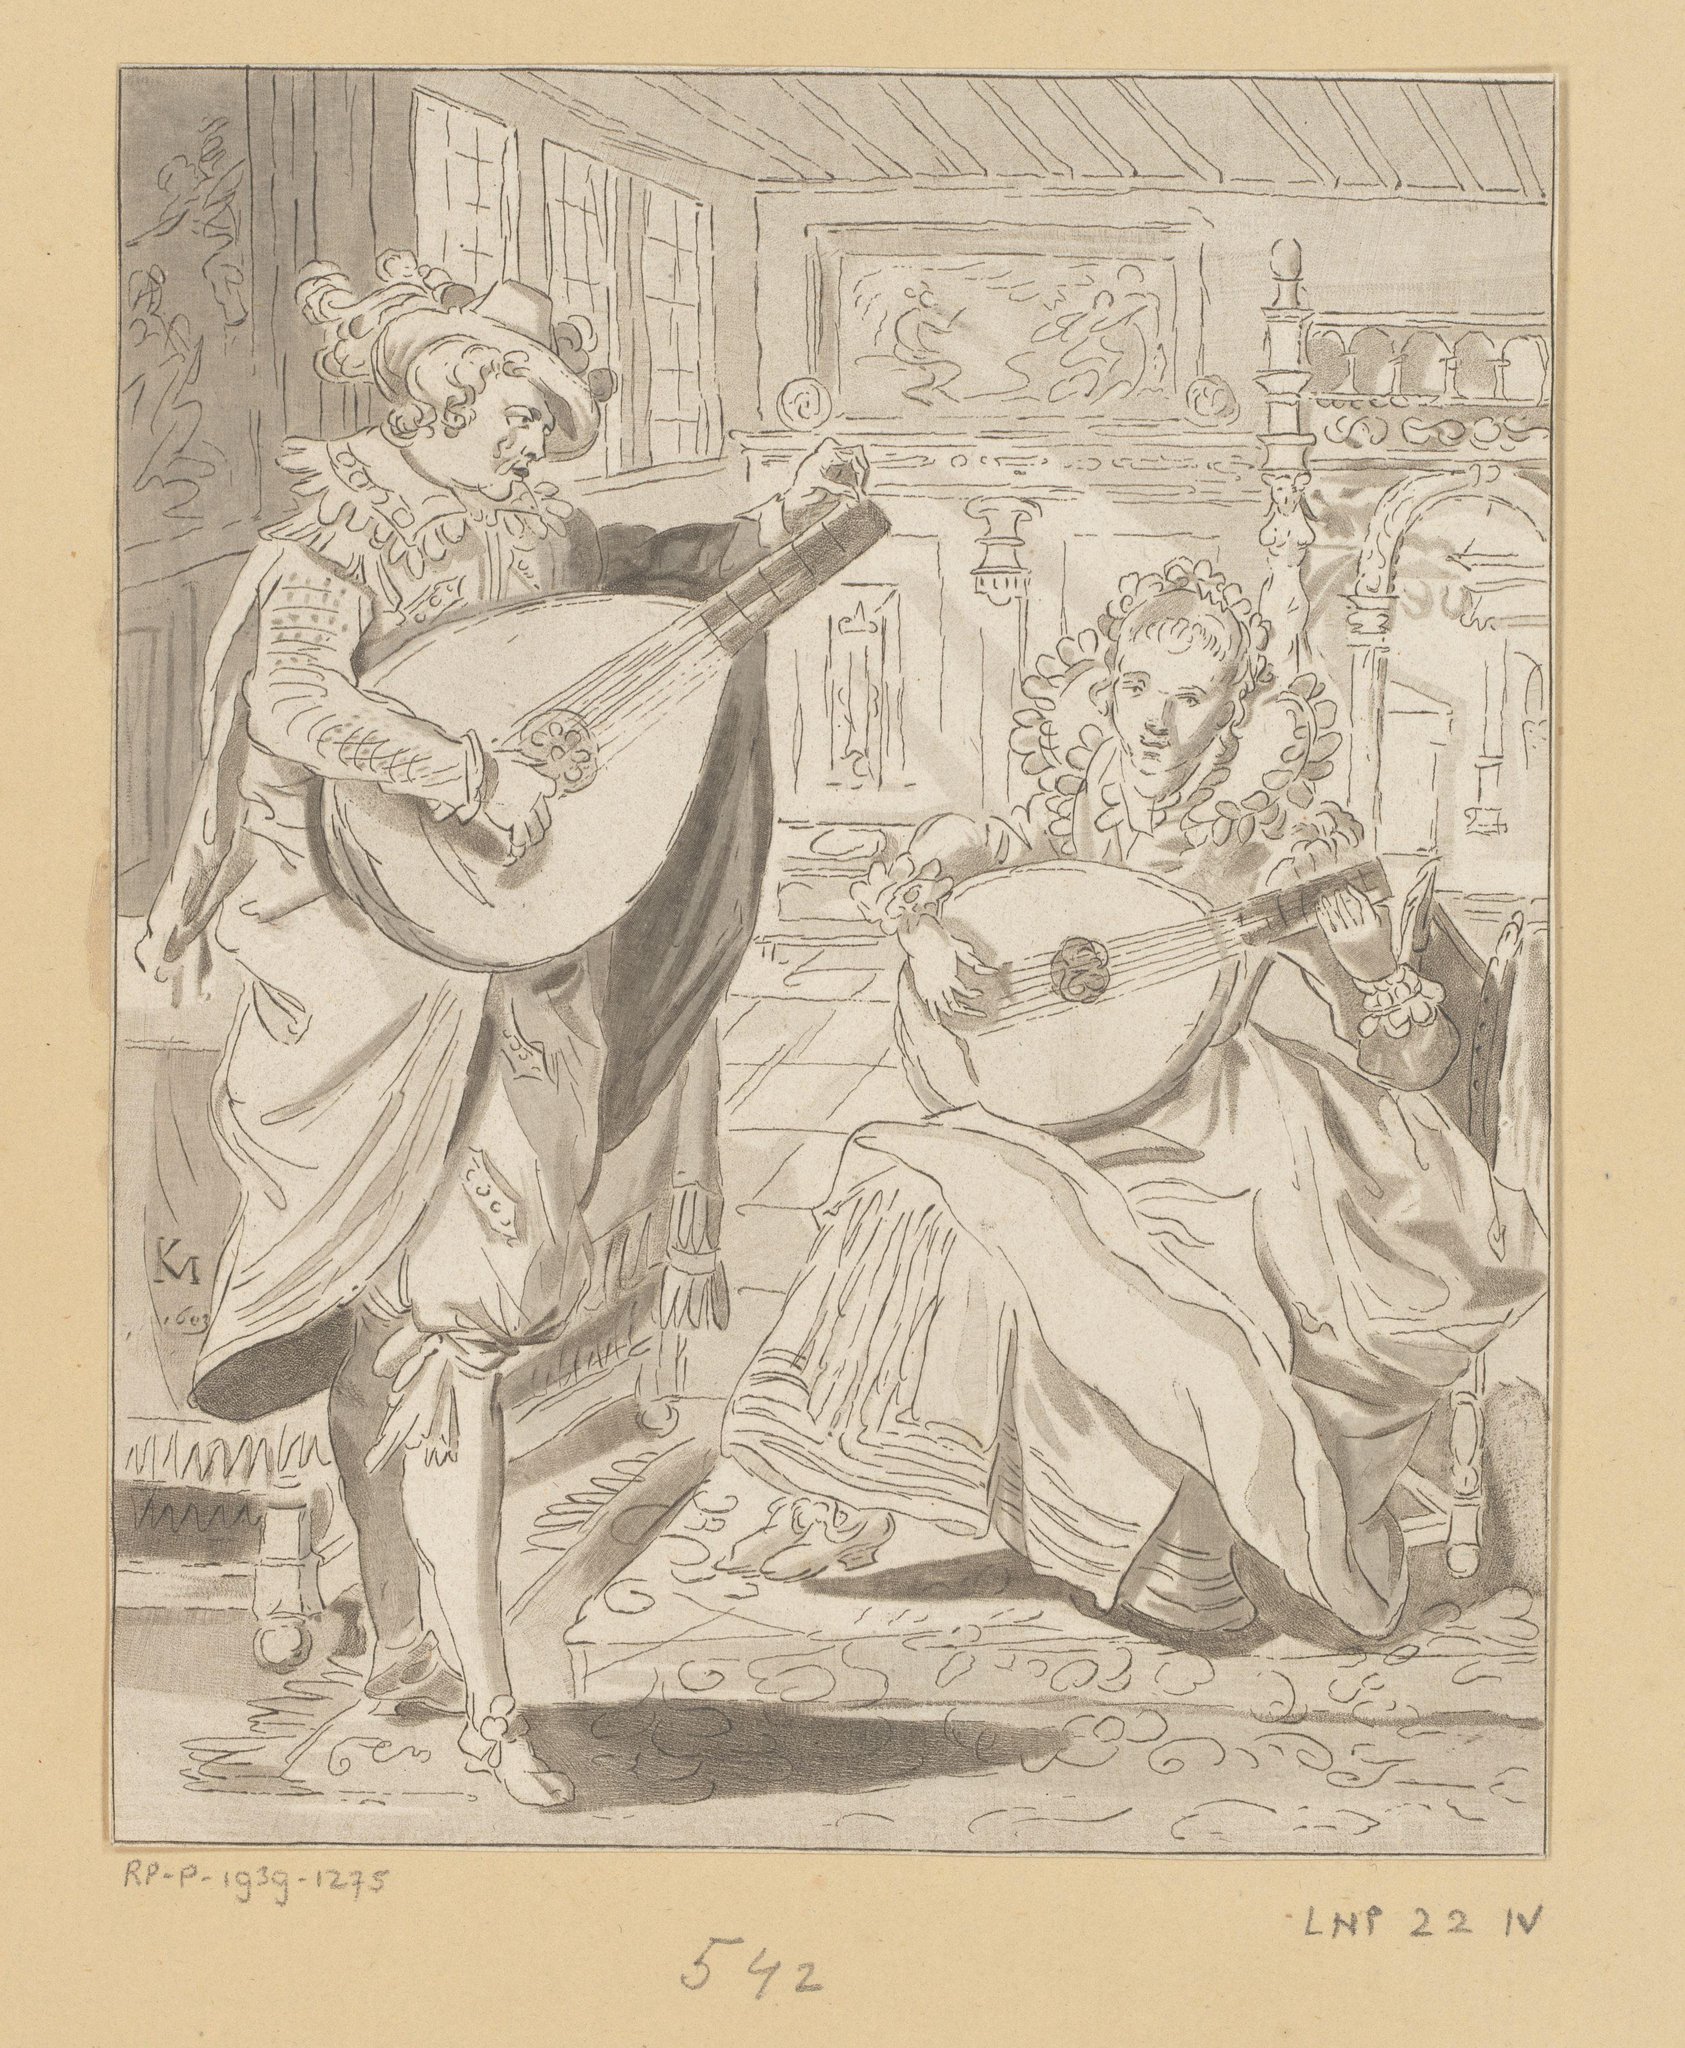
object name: print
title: Luitspelende heer en dame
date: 1772-1774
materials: paper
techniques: etching, hand coloring, roulette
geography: amsterdam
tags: interior of the house, lute, and special forms of lute, e.g.: theorbo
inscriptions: collector's mark: Lugt 2725, collector's mark: ‘RIJKS / MUSM’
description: Interieur met een man en een vrouw, die allebei de luit bespelen. De prent ligt los in een album, zie blad 22.